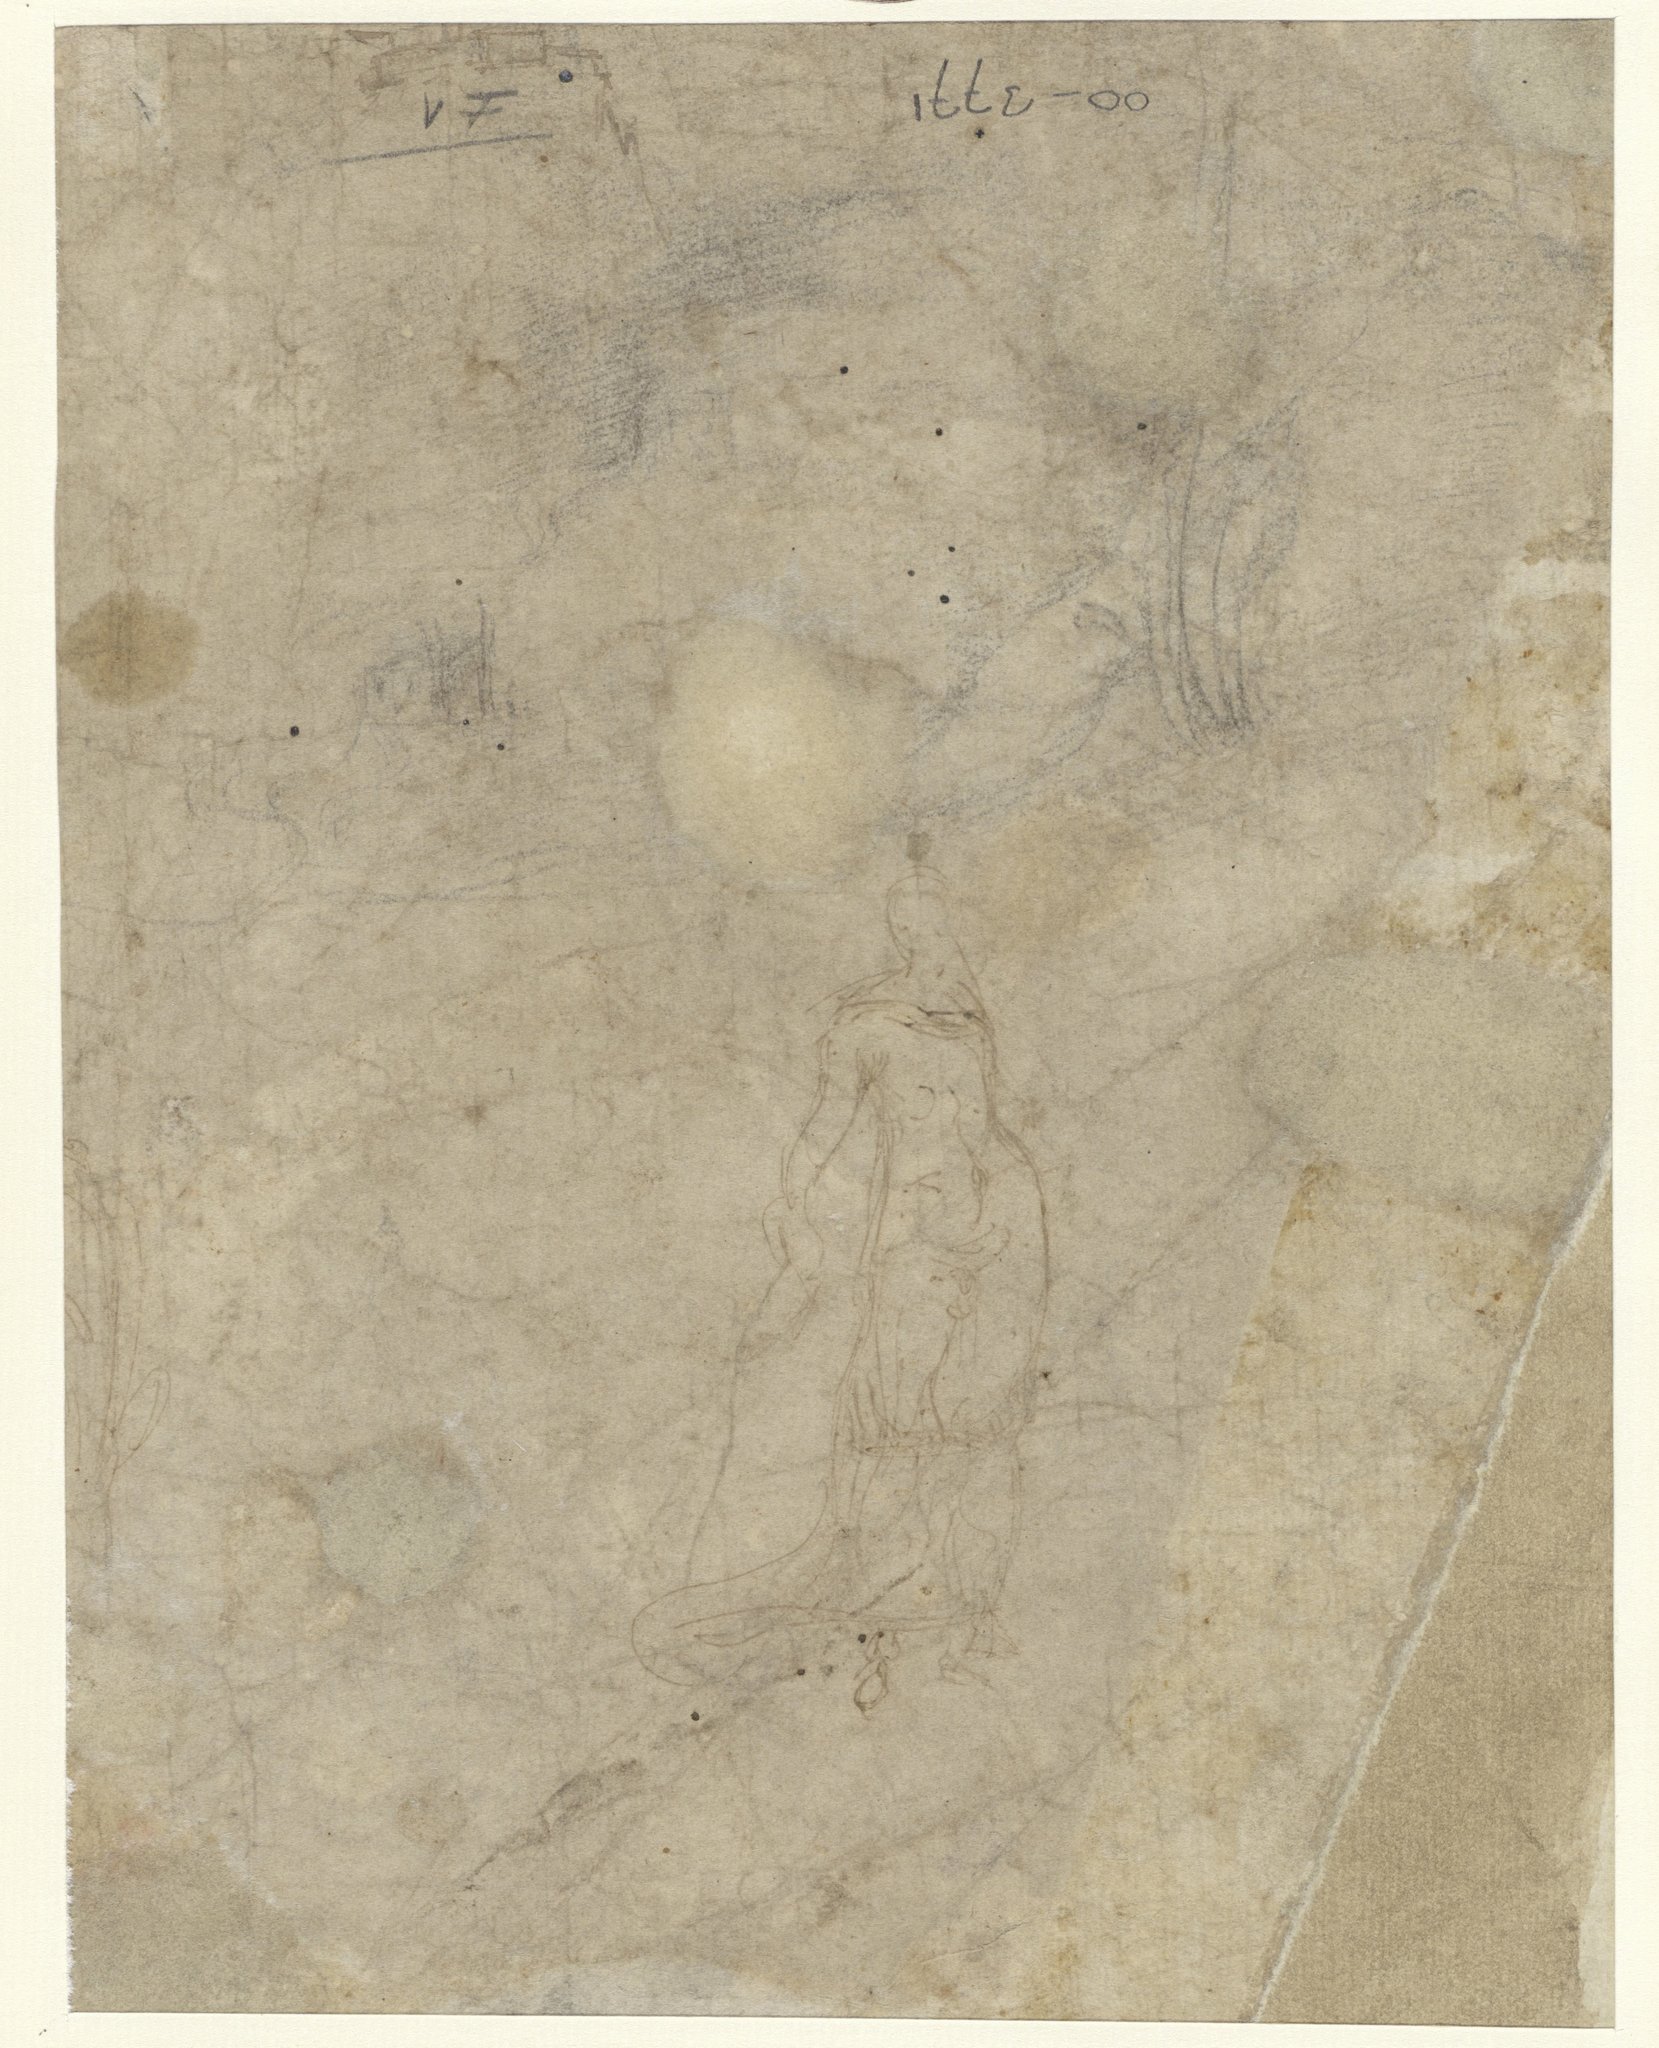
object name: drawing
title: Schets van een vrouw en een landschap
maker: Anonymous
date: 1480-1600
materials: chalk, ink, paper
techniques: pen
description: Schets van een staande vrouw en een landschap met een heuvel en een boom.